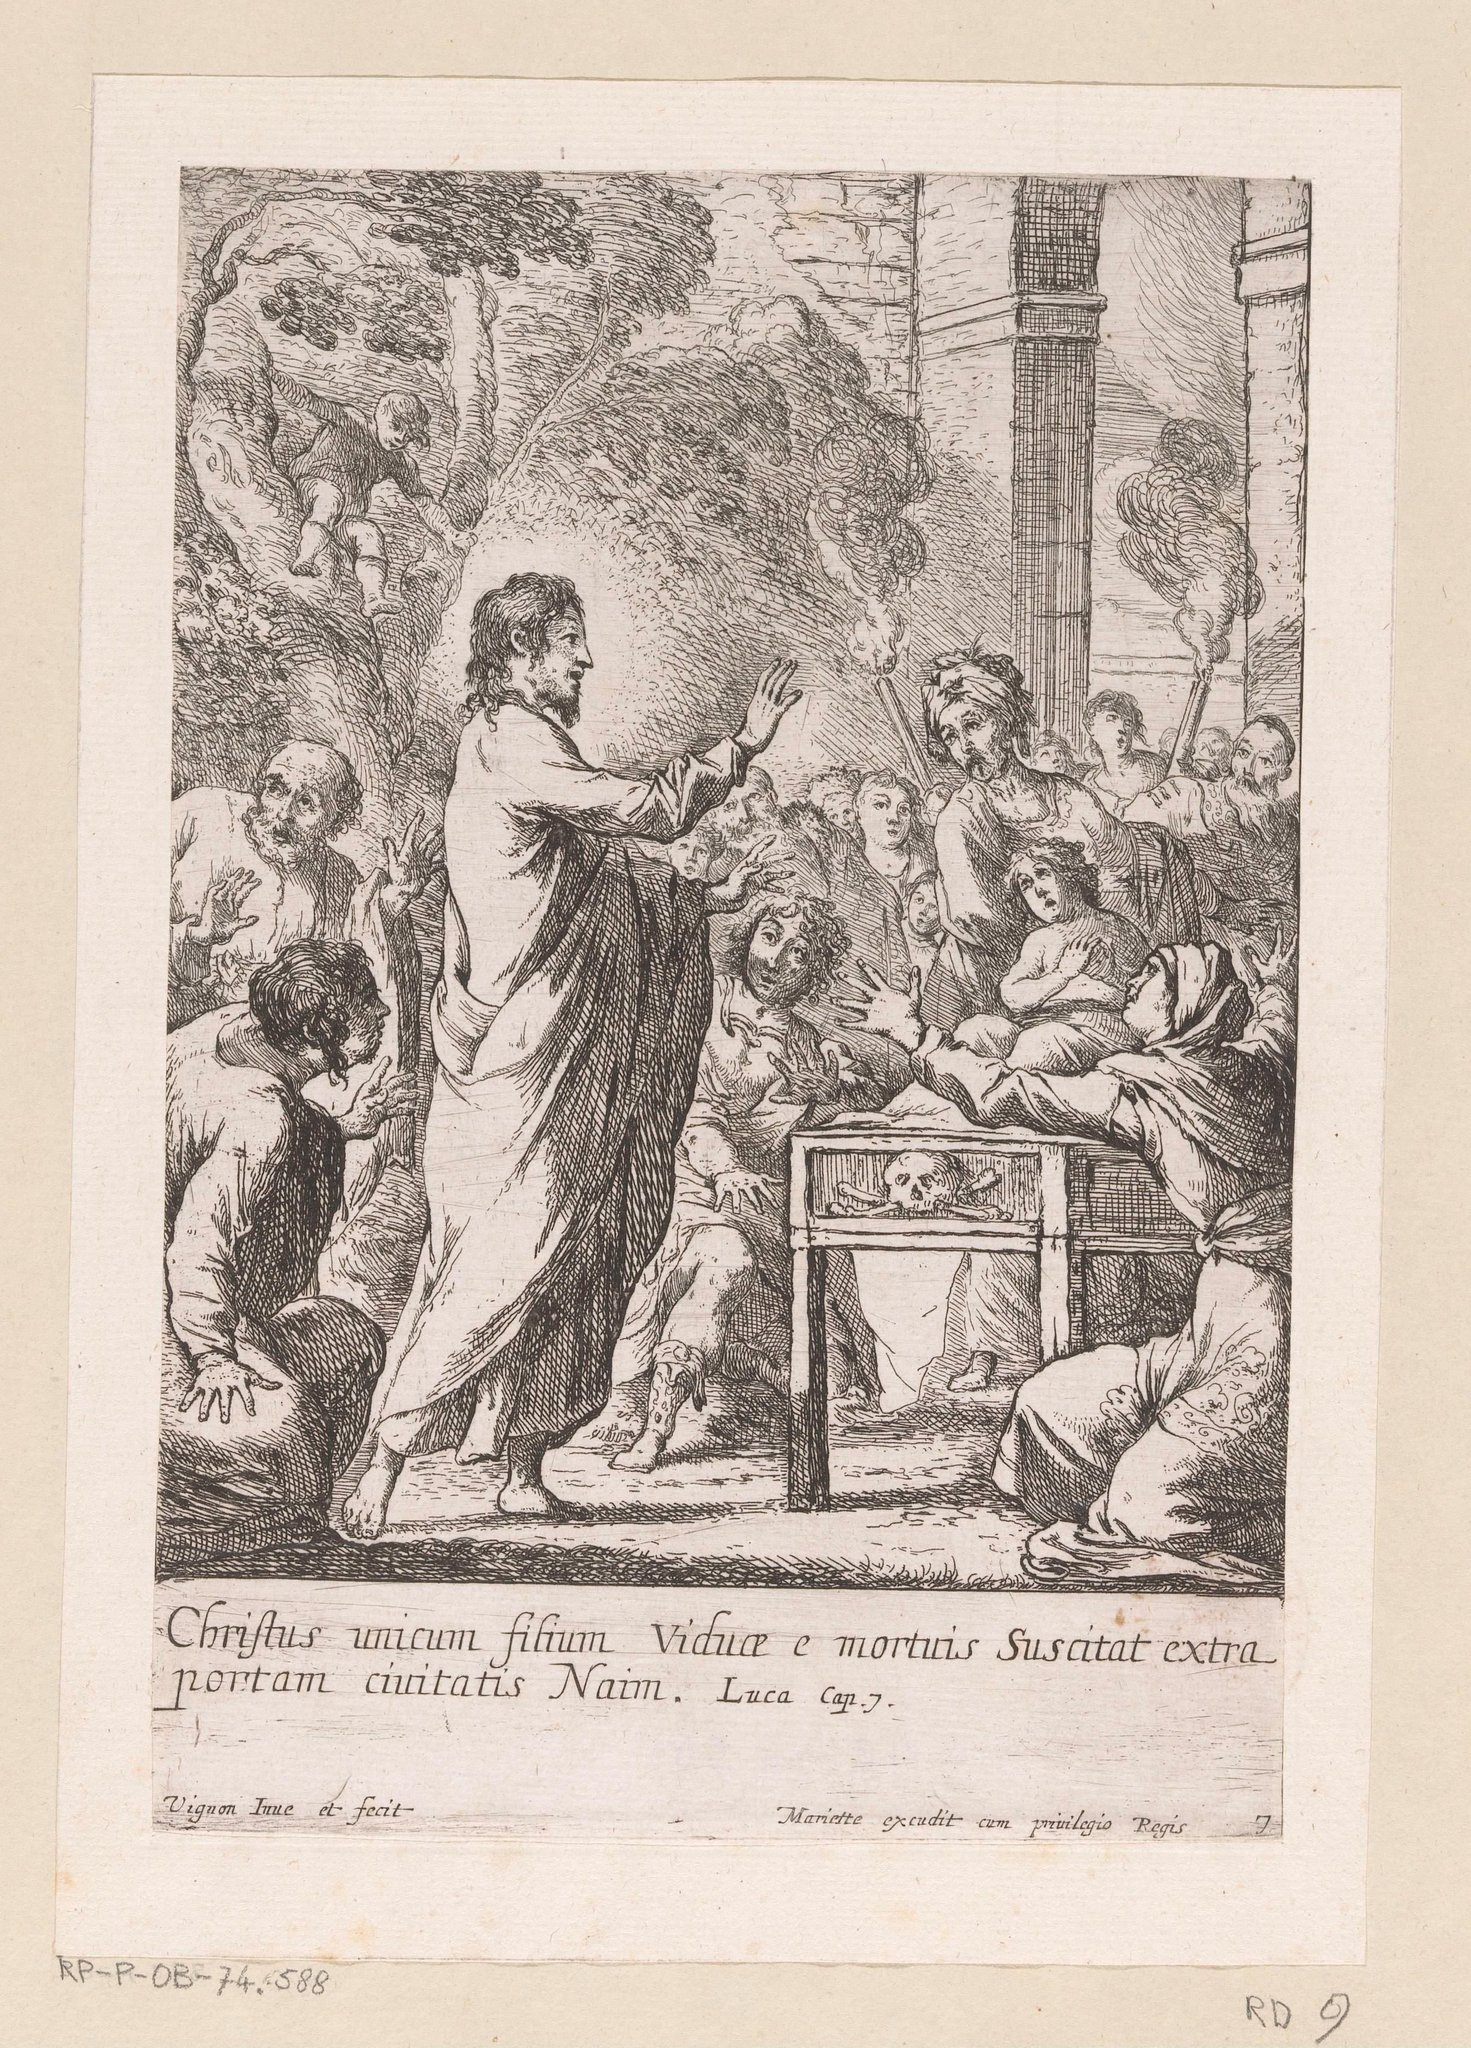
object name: print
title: Opwekking van de jongeling te Naïn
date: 1638-1643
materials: paper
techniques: drypoint, etching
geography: paris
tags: christ touches the bier of the son of the widow of nain: the young man sits up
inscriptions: collector's mark: Lugt 240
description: Maakt deel uit van een serie van dertien prenten voorstellende de wonderen van Christus, opgedragen aan de arts Charles Delorme (1584-1678).